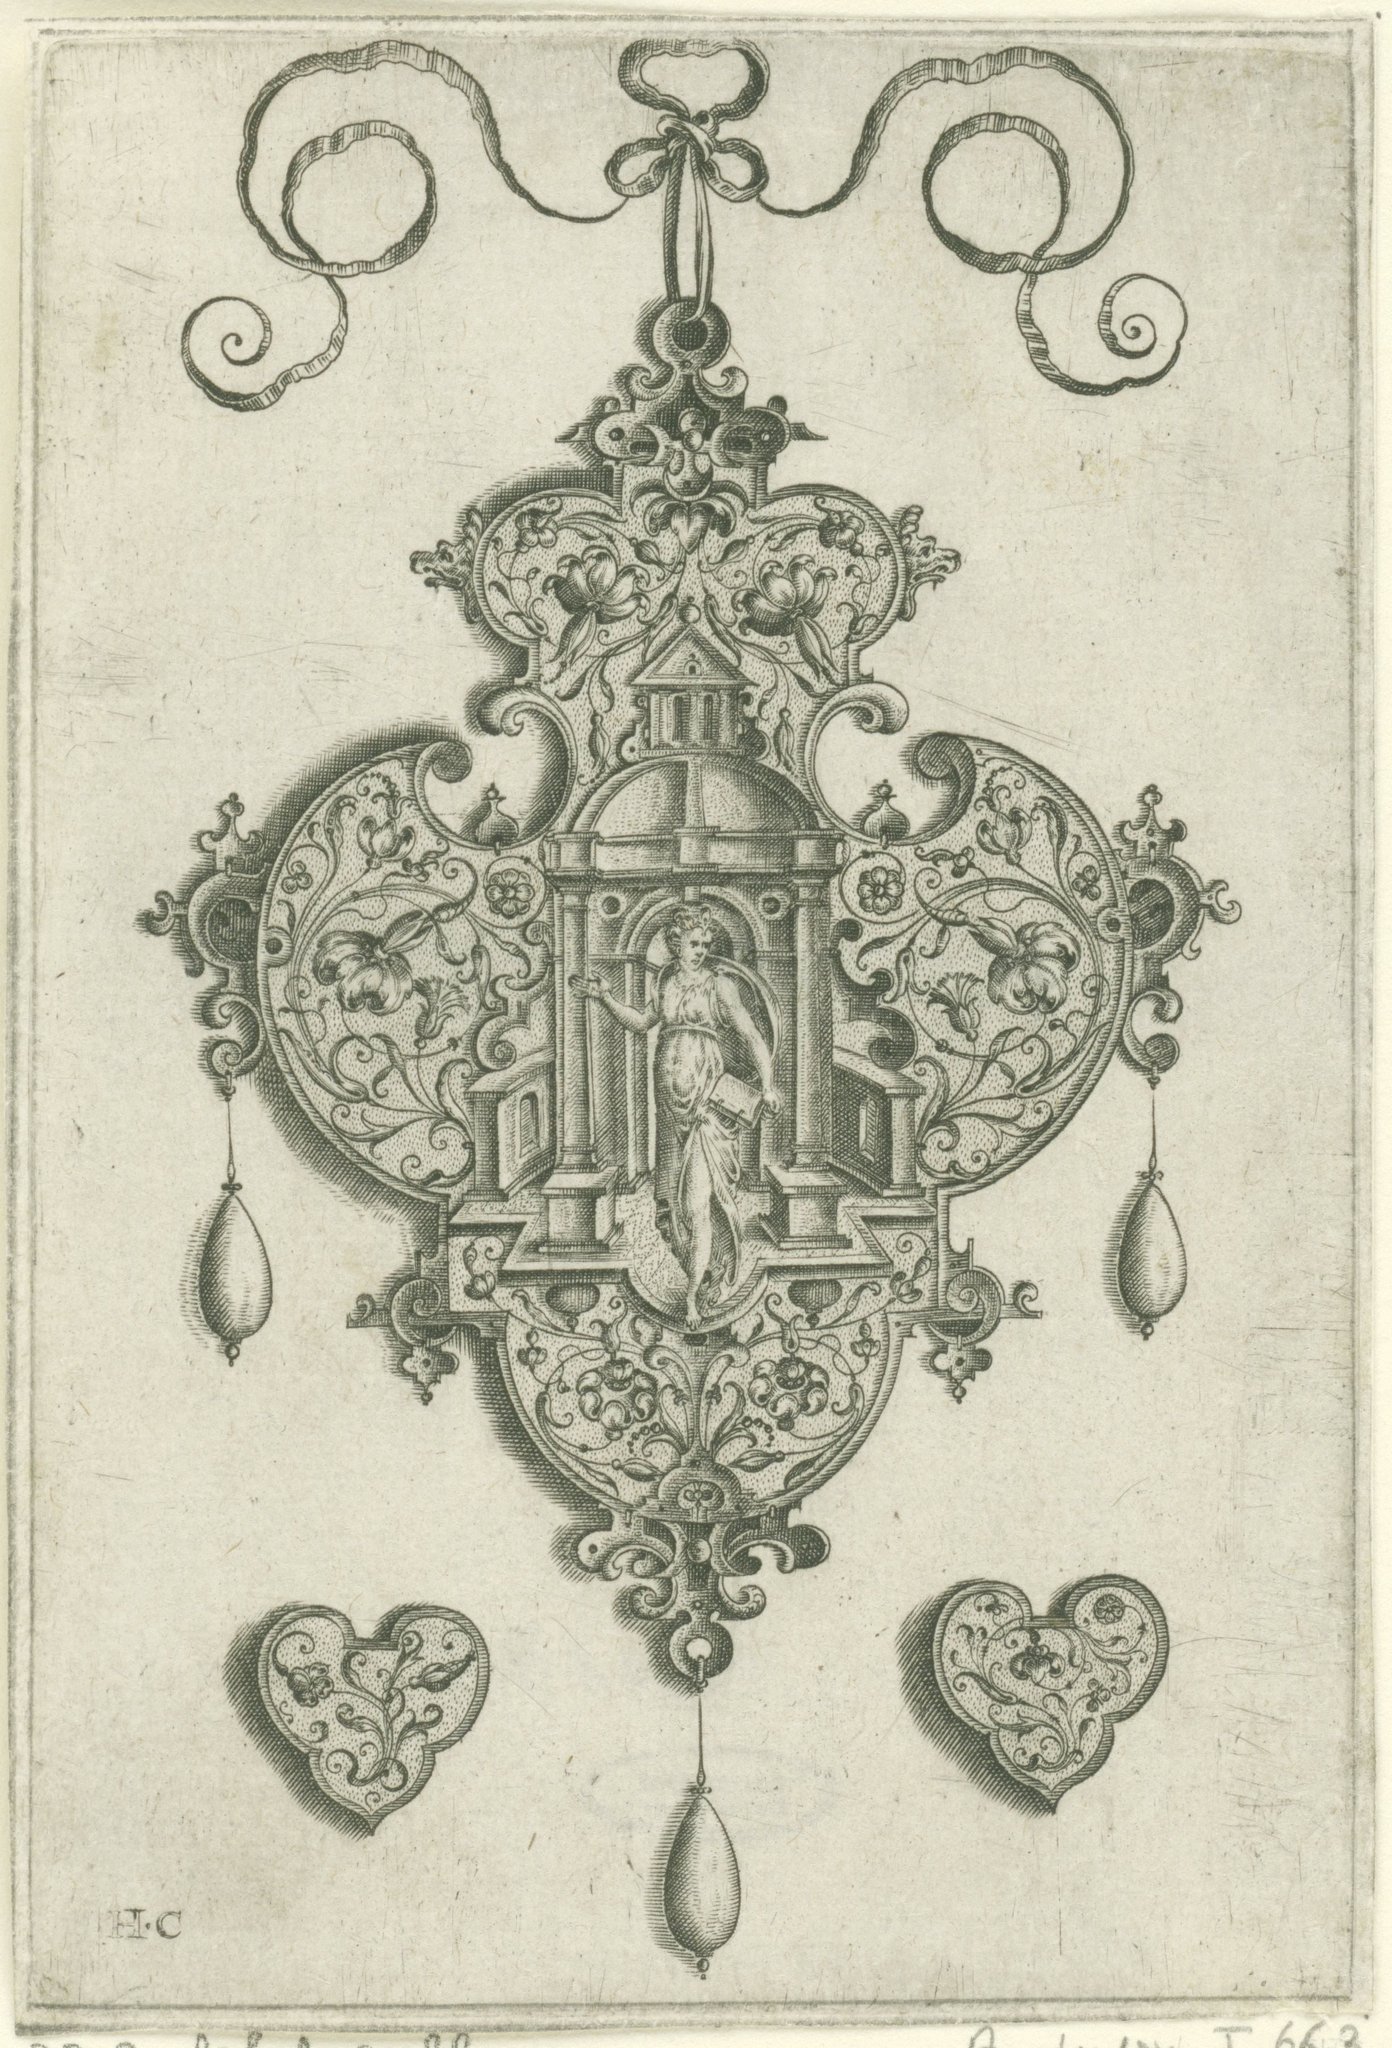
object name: print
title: Hangers met arabesken en figuren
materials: paper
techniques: engraving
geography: netherlands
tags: accessories (~ clothing), pendant, trinket, 'breloque', 'sapientia', mother of the seven virtues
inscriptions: monogram: ‘H.C.’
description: Voorzijde van een hanger (pendeloque). In het midden een nis met een koepel. In de nis de personificatie van het Geloof (Fides): een staande vrouw met een boek in de linkerhand. Linksonder en rechtsonder een hartvormig kostuumornament. Een van 6 bladen afkomstig uit een serie van 10 bladen met hangers. Aan iedere hanger hangen drie parels. Op elk blad bovendien nog twee of vier kleine kostuumornamenten.